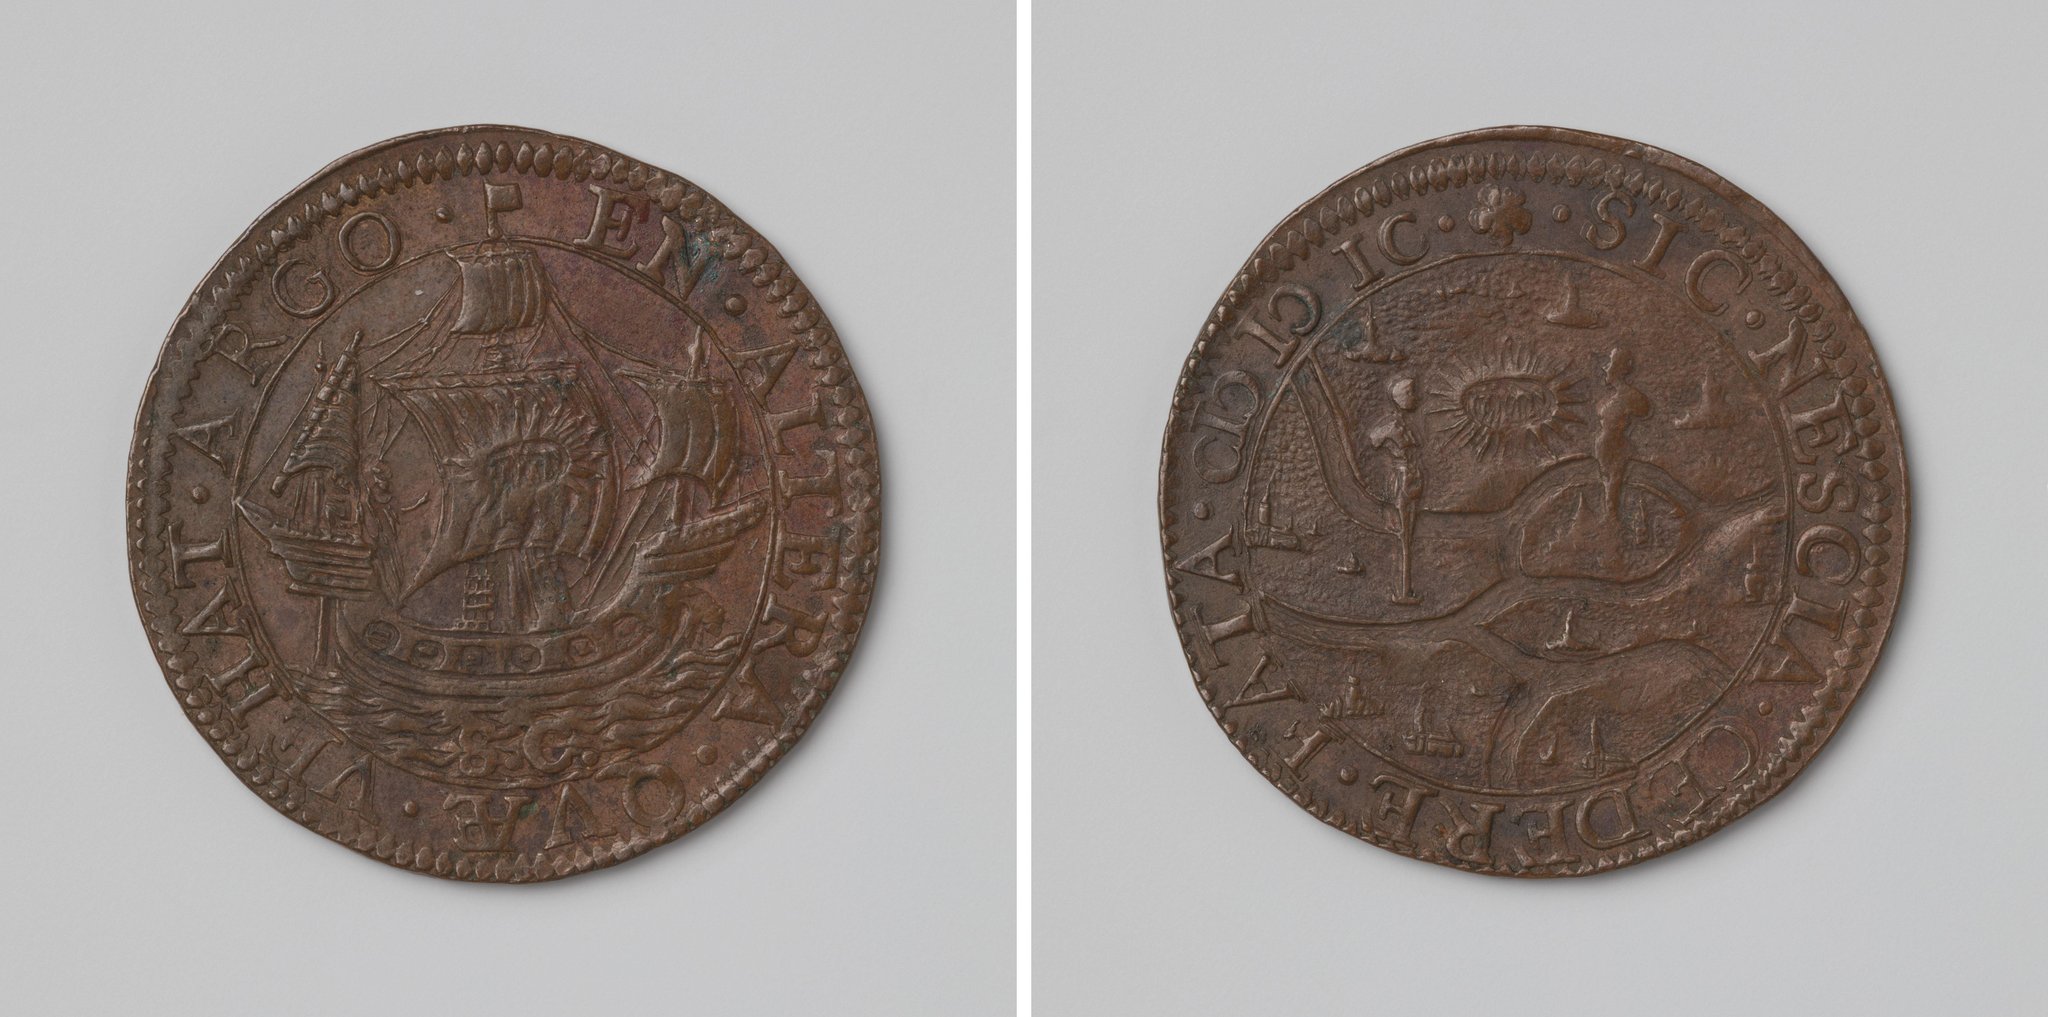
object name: jeton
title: De tocht van admiraal van der Does naar de Canarische eilanden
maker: Anonymous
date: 1599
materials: copper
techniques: striking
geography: dordrecht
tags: the hague, maurice (prince of orange), politician